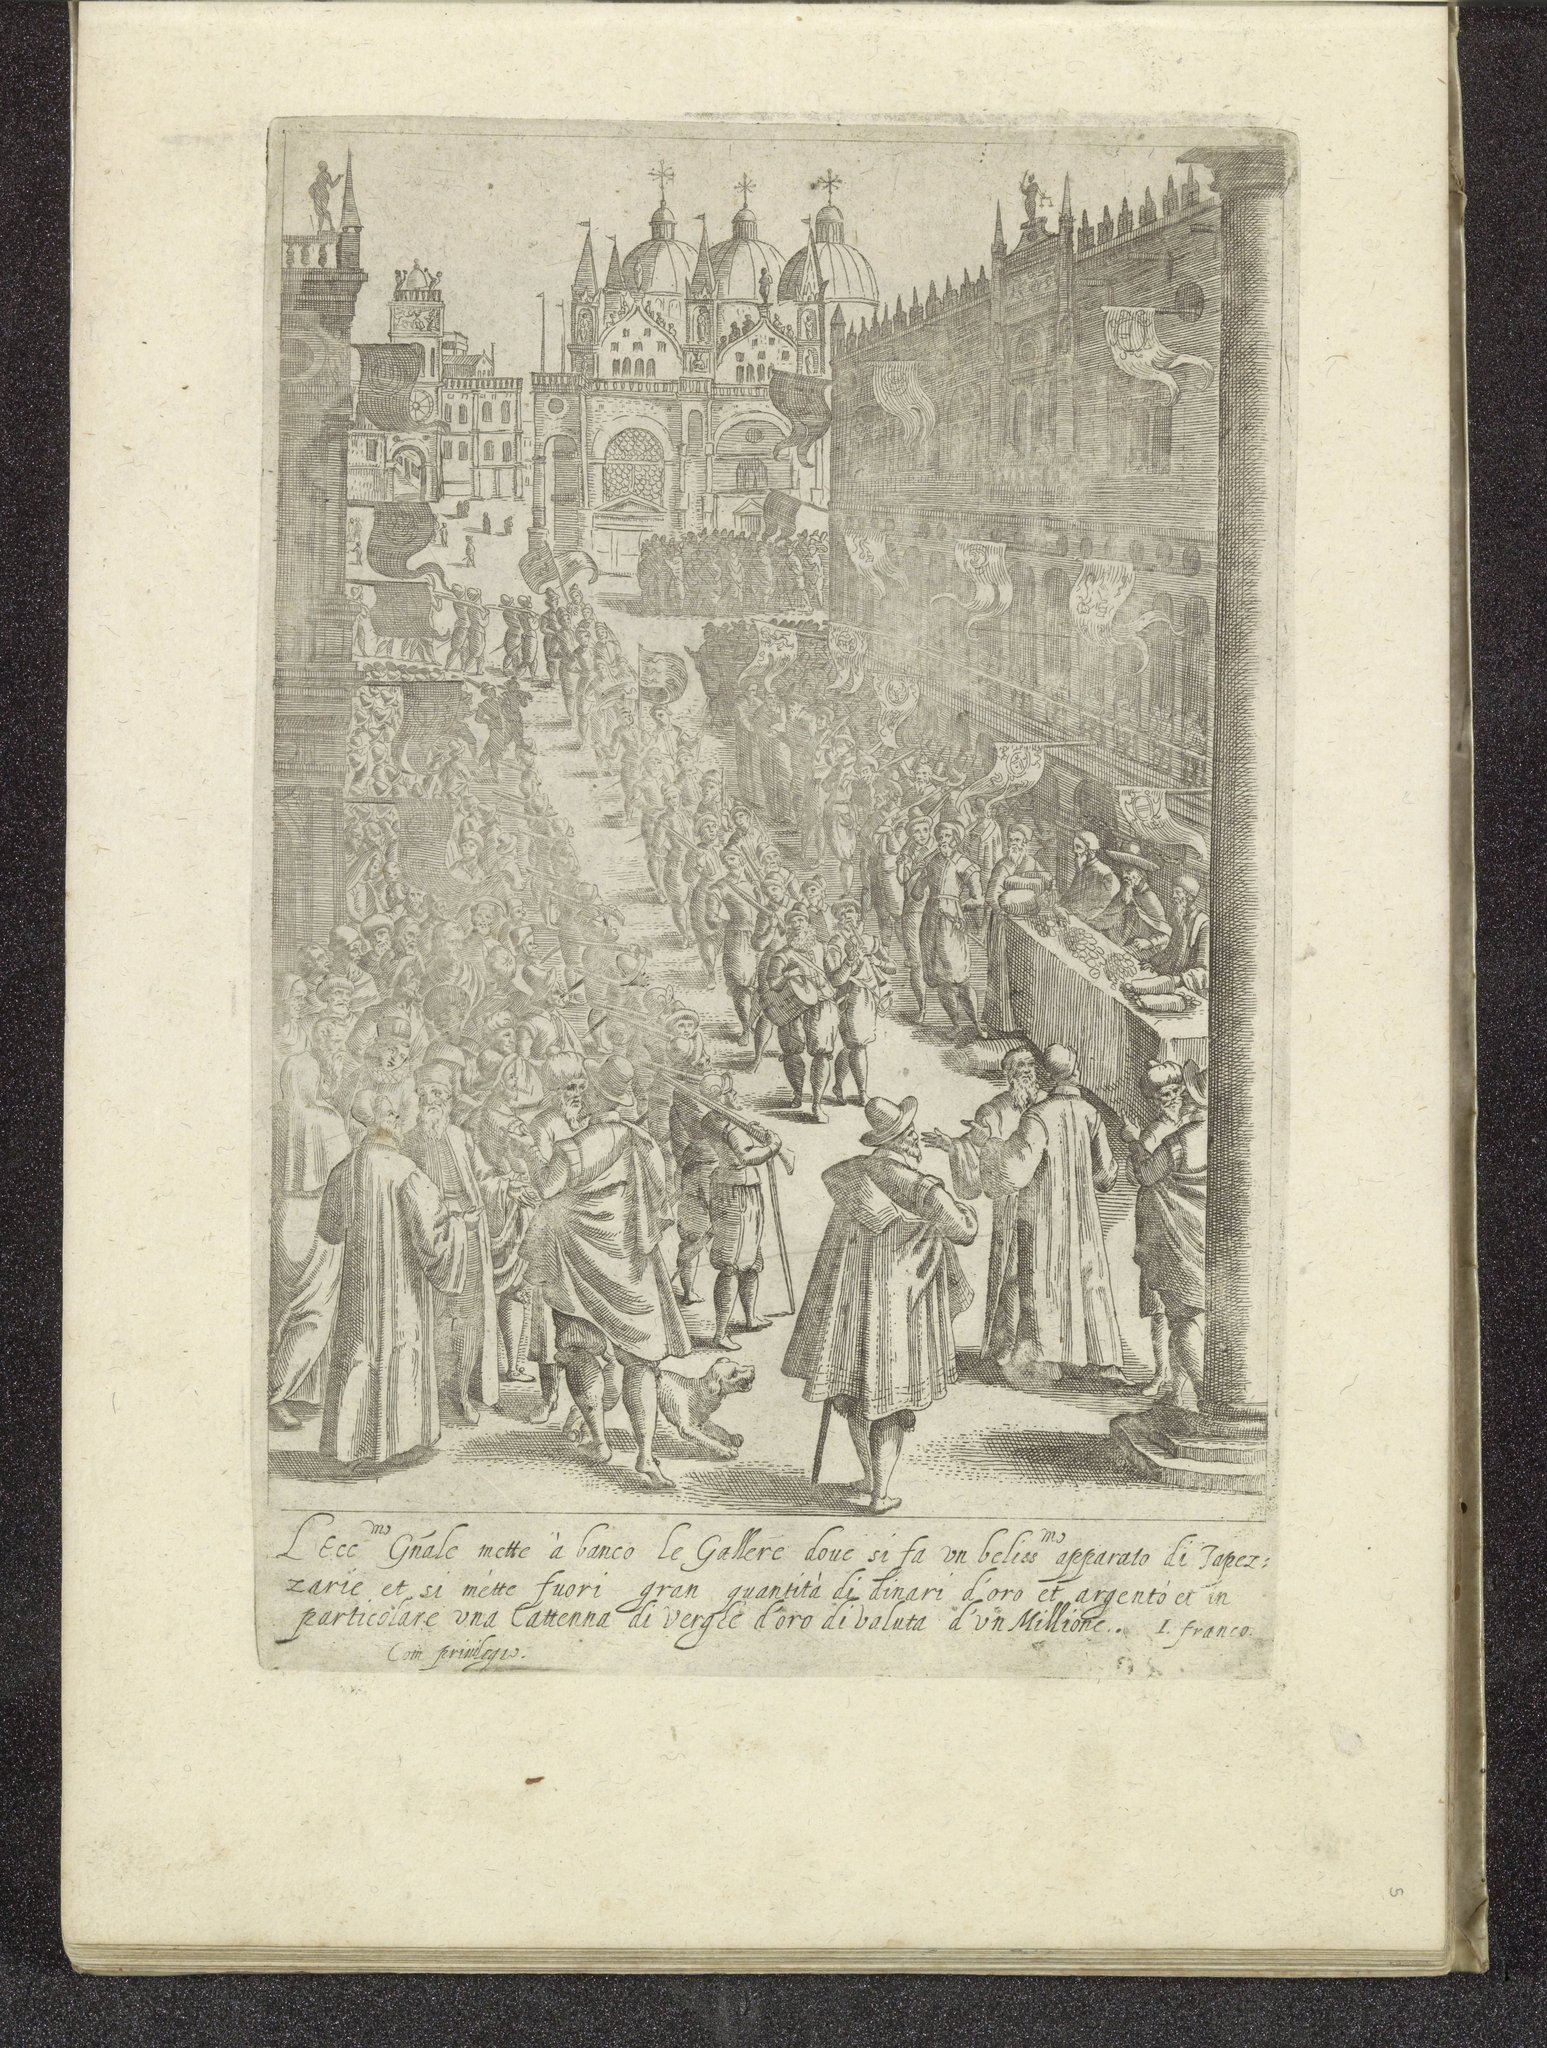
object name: album leaf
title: Optocht op het San Marcoplein te Venetië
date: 1610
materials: paper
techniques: engraving, etching, intaglio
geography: venice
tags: square, place, circus, etc., musical instruments; group of musical instruments, venice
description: Drieregelige Italiaanse tekst in ondermarge. De prent maakt deel uit van een album.